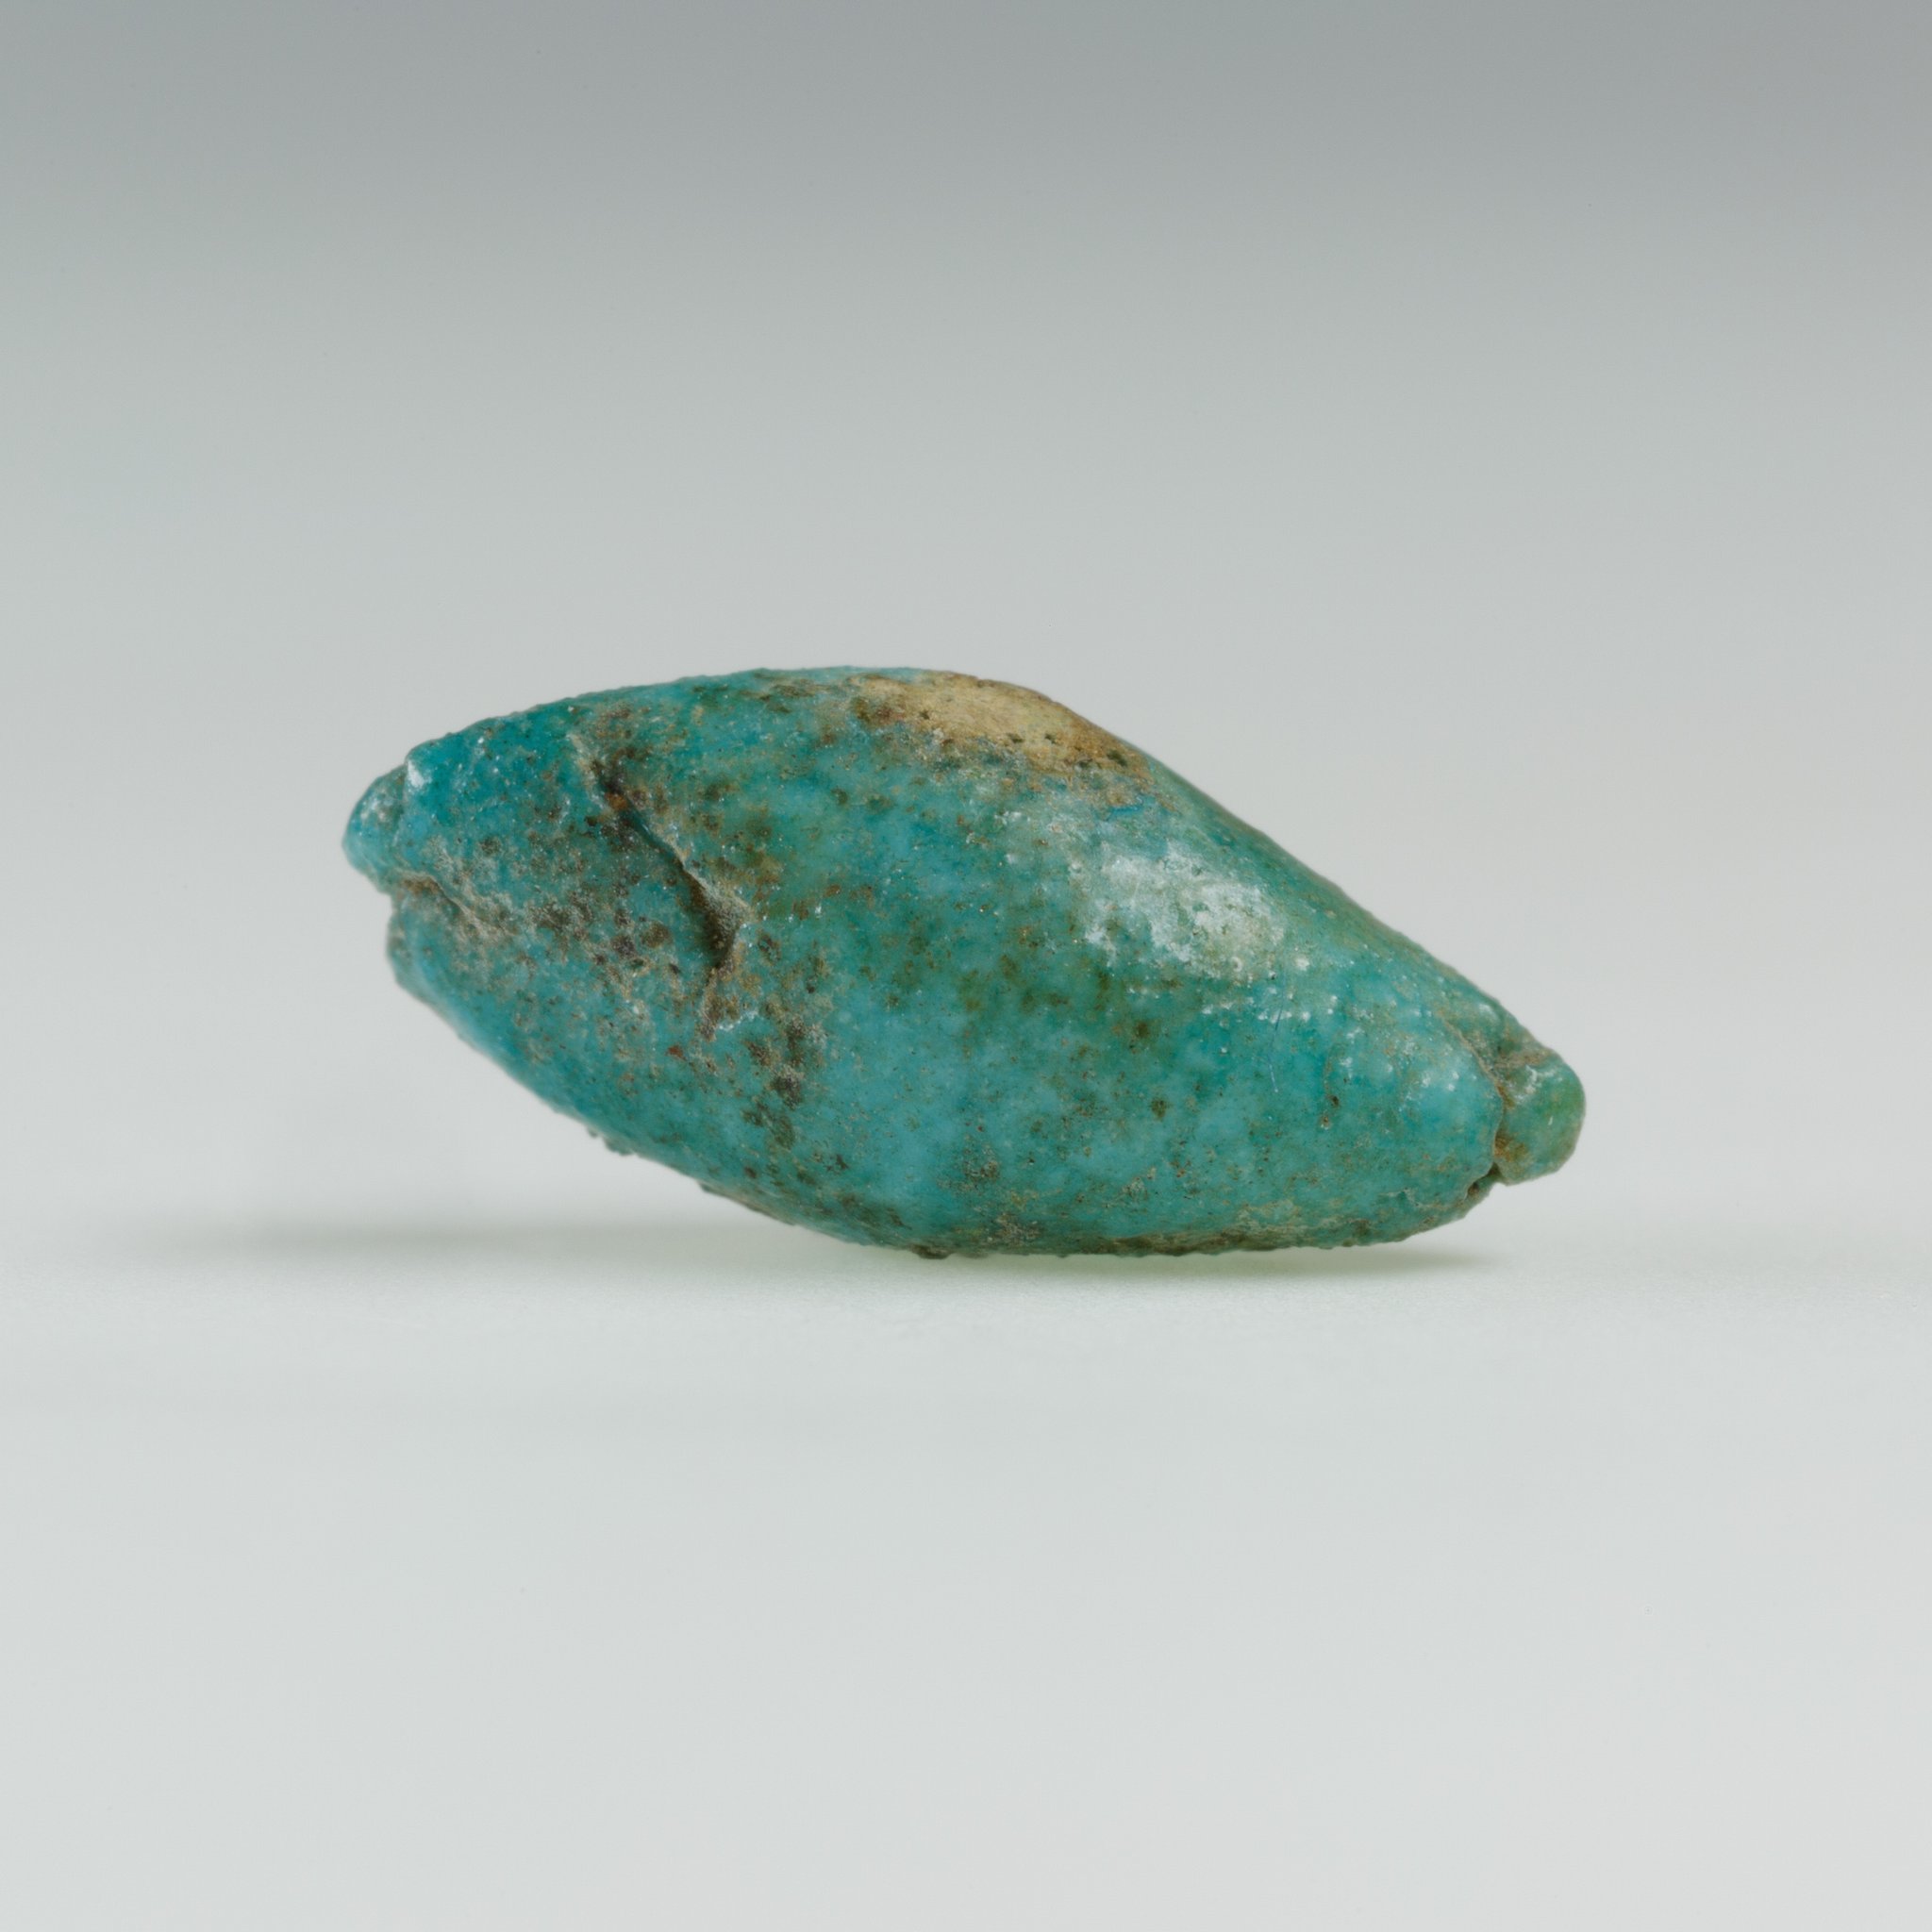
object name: bead, amenemhat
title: Unfinished Bead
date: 1504-1447 BCE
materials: faience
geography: egypt